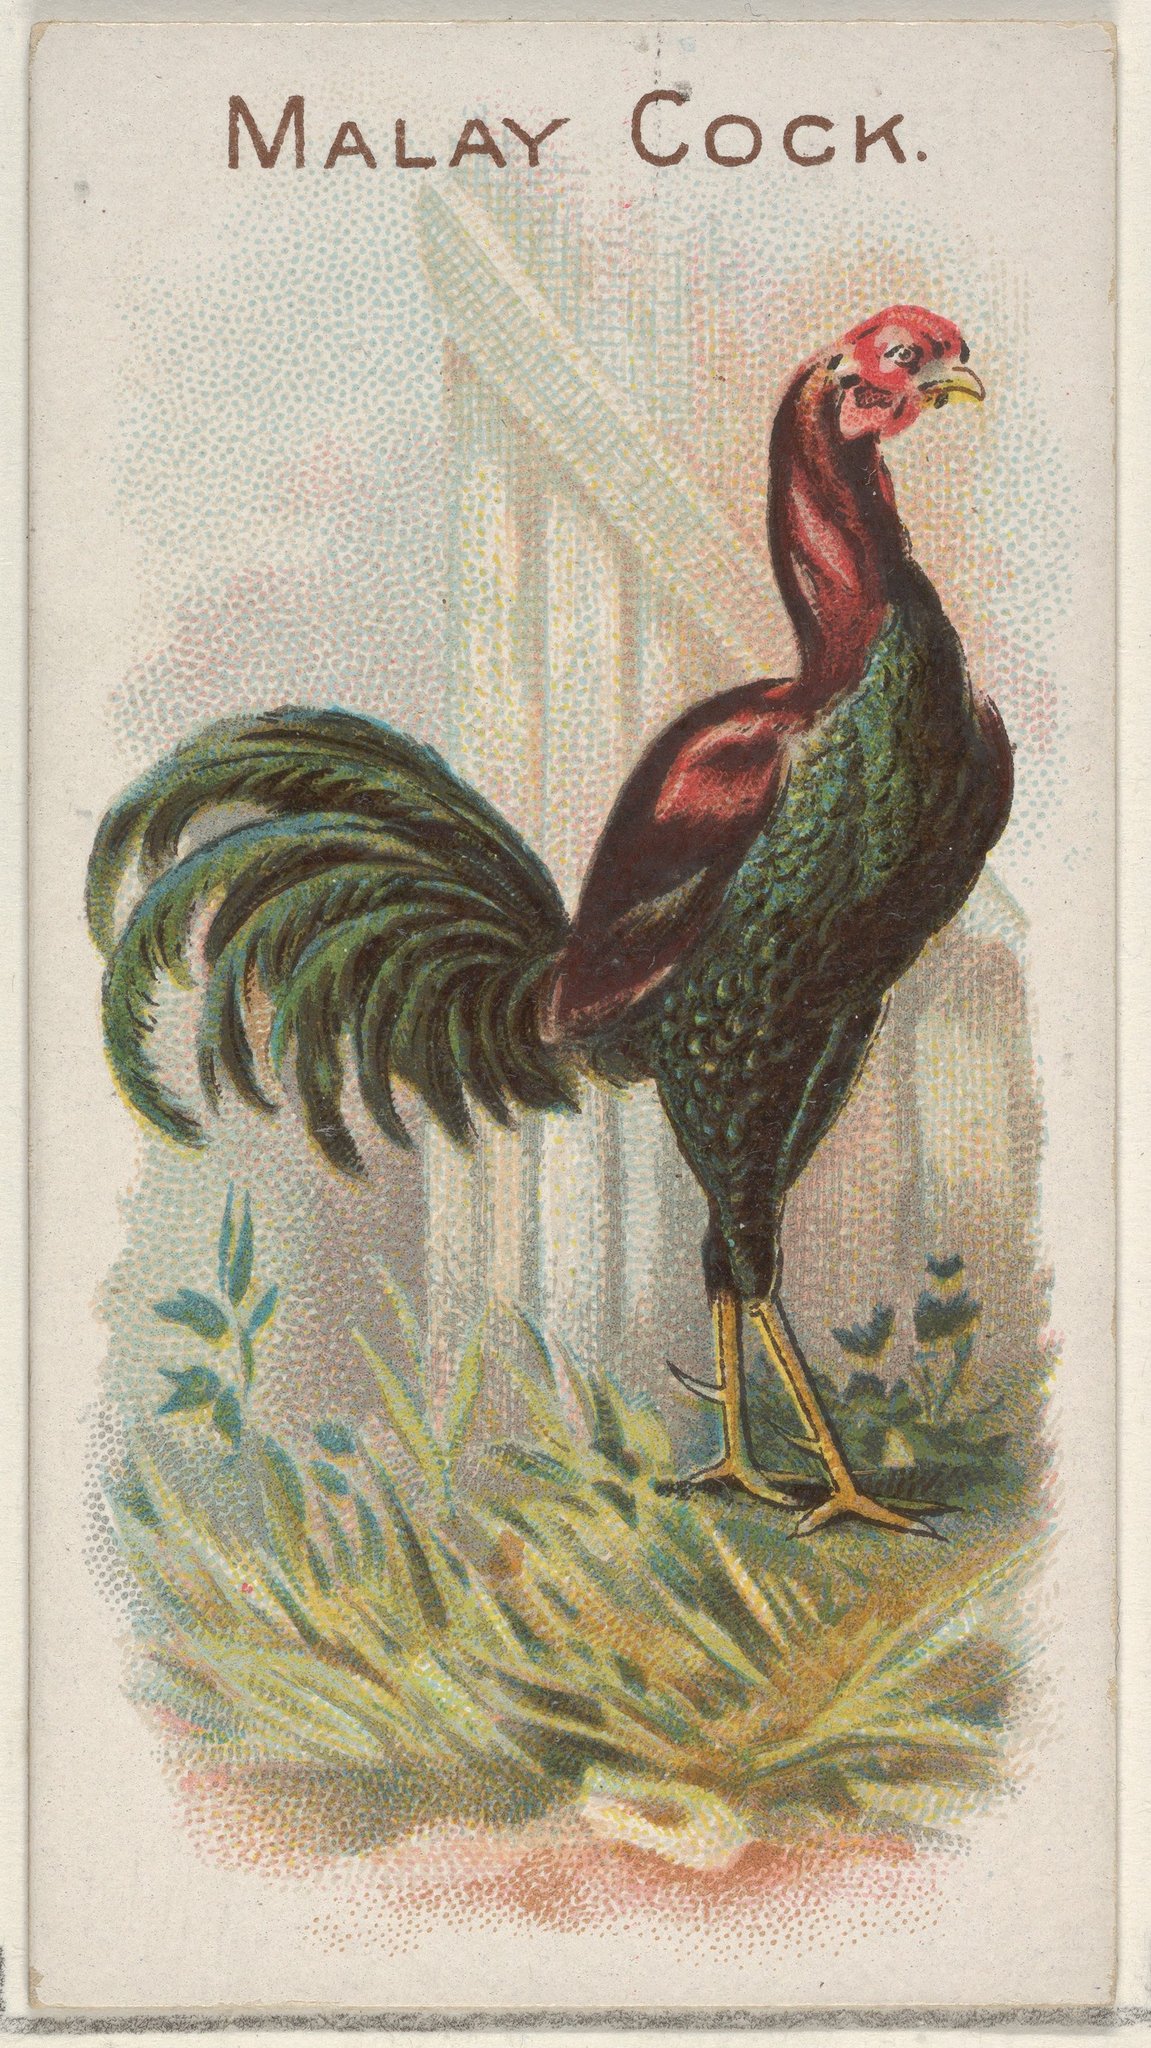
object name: print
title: Malay Cock, from the Prize and Game Chickens series (N20) for Allen & Ginter Cigarettes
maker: allen & ginter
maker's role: publisher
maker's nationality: american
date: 1891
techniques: color lithograph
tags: roosters